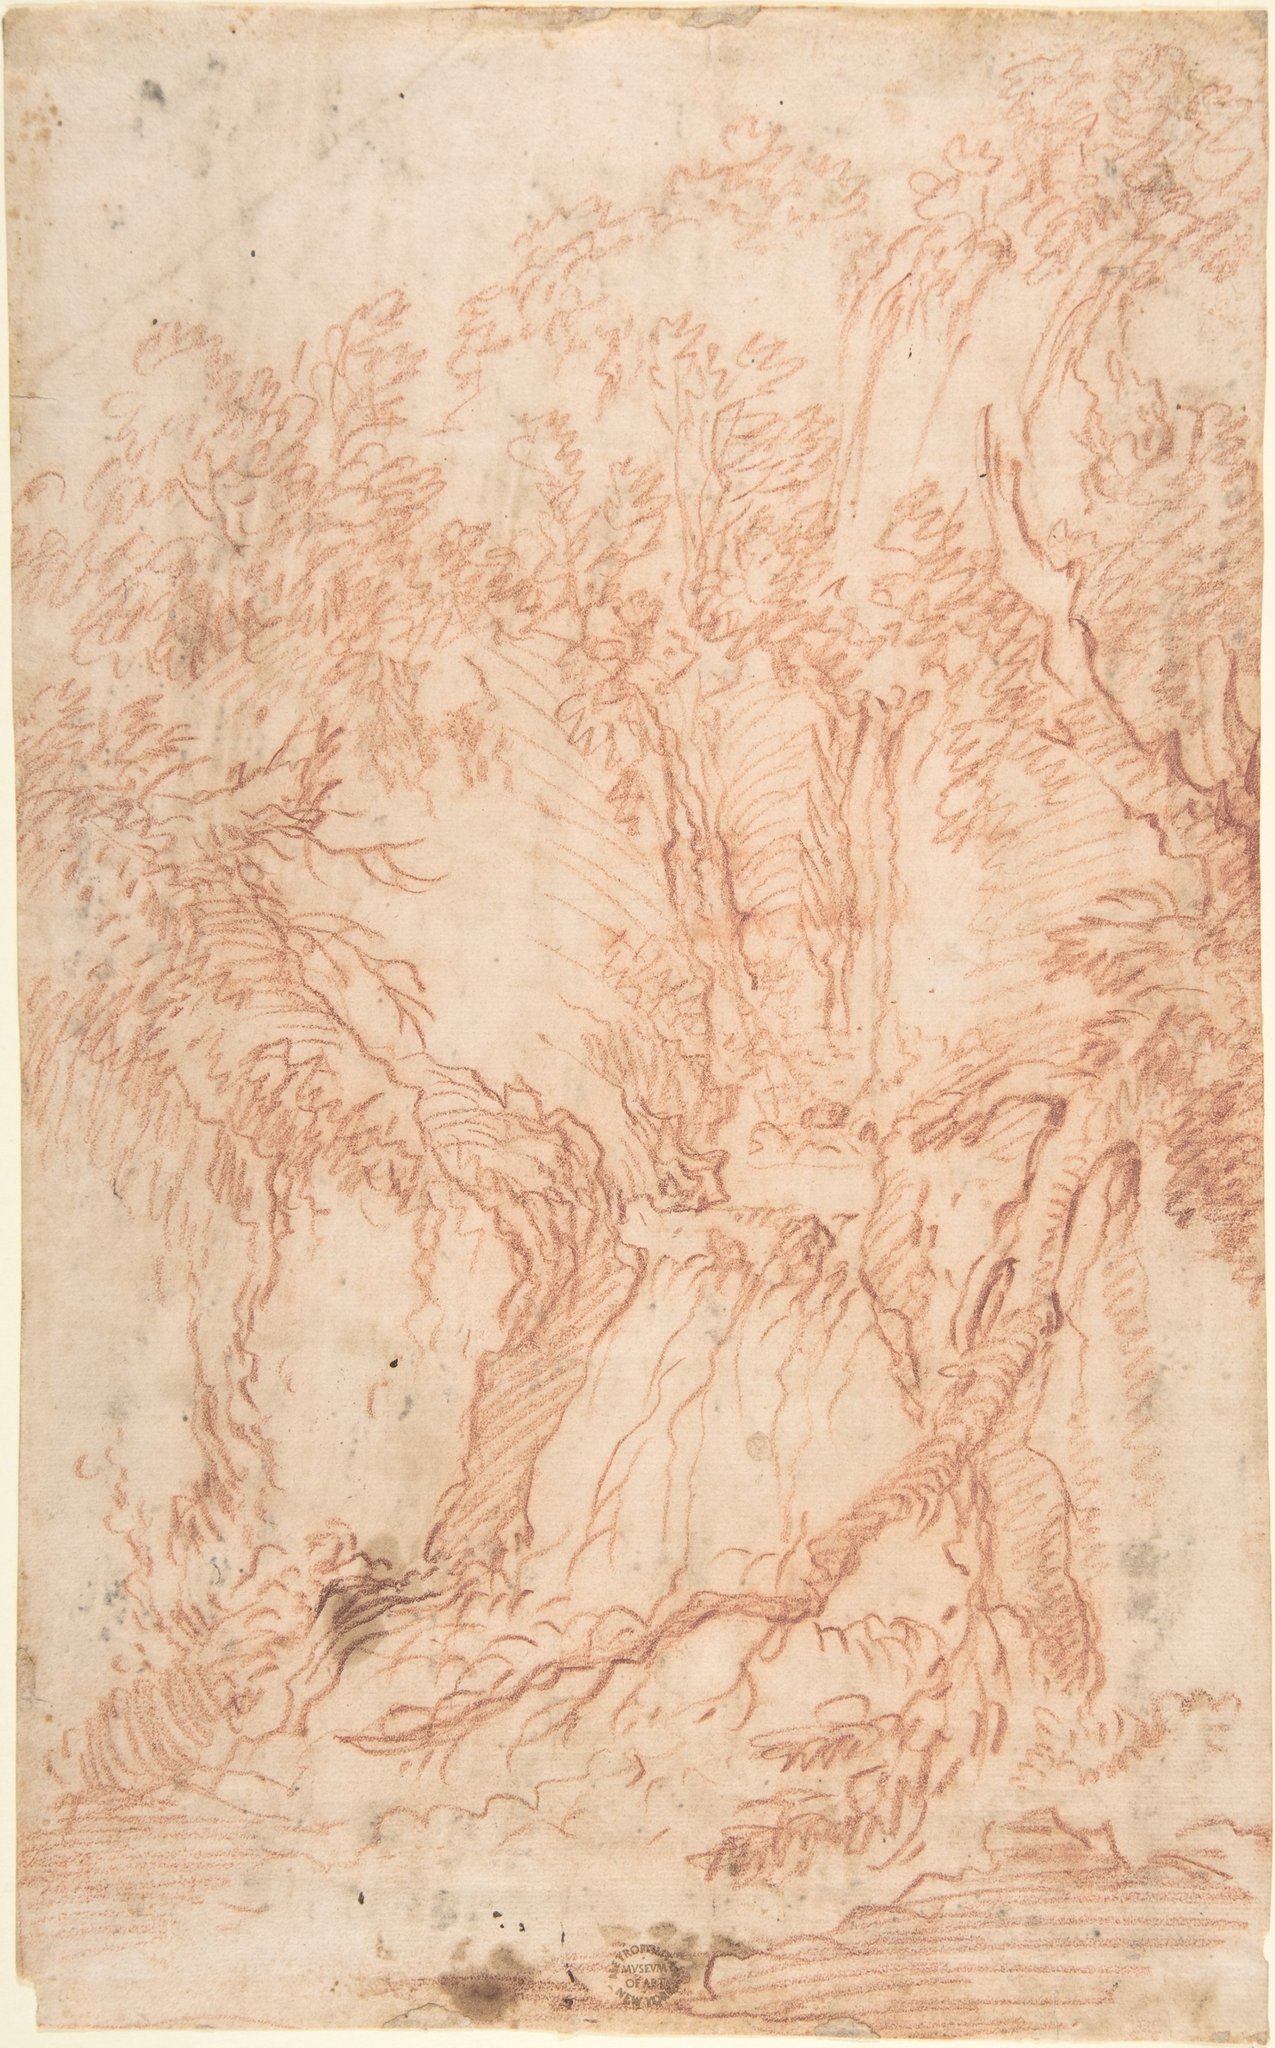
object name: drawing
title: Trees and Rocks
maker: anonymous, italian, roman-bolognese, 17th century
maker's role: artist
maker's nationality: italian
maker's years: 1600-1700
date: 1601-1700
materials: chalk, paper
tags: trees